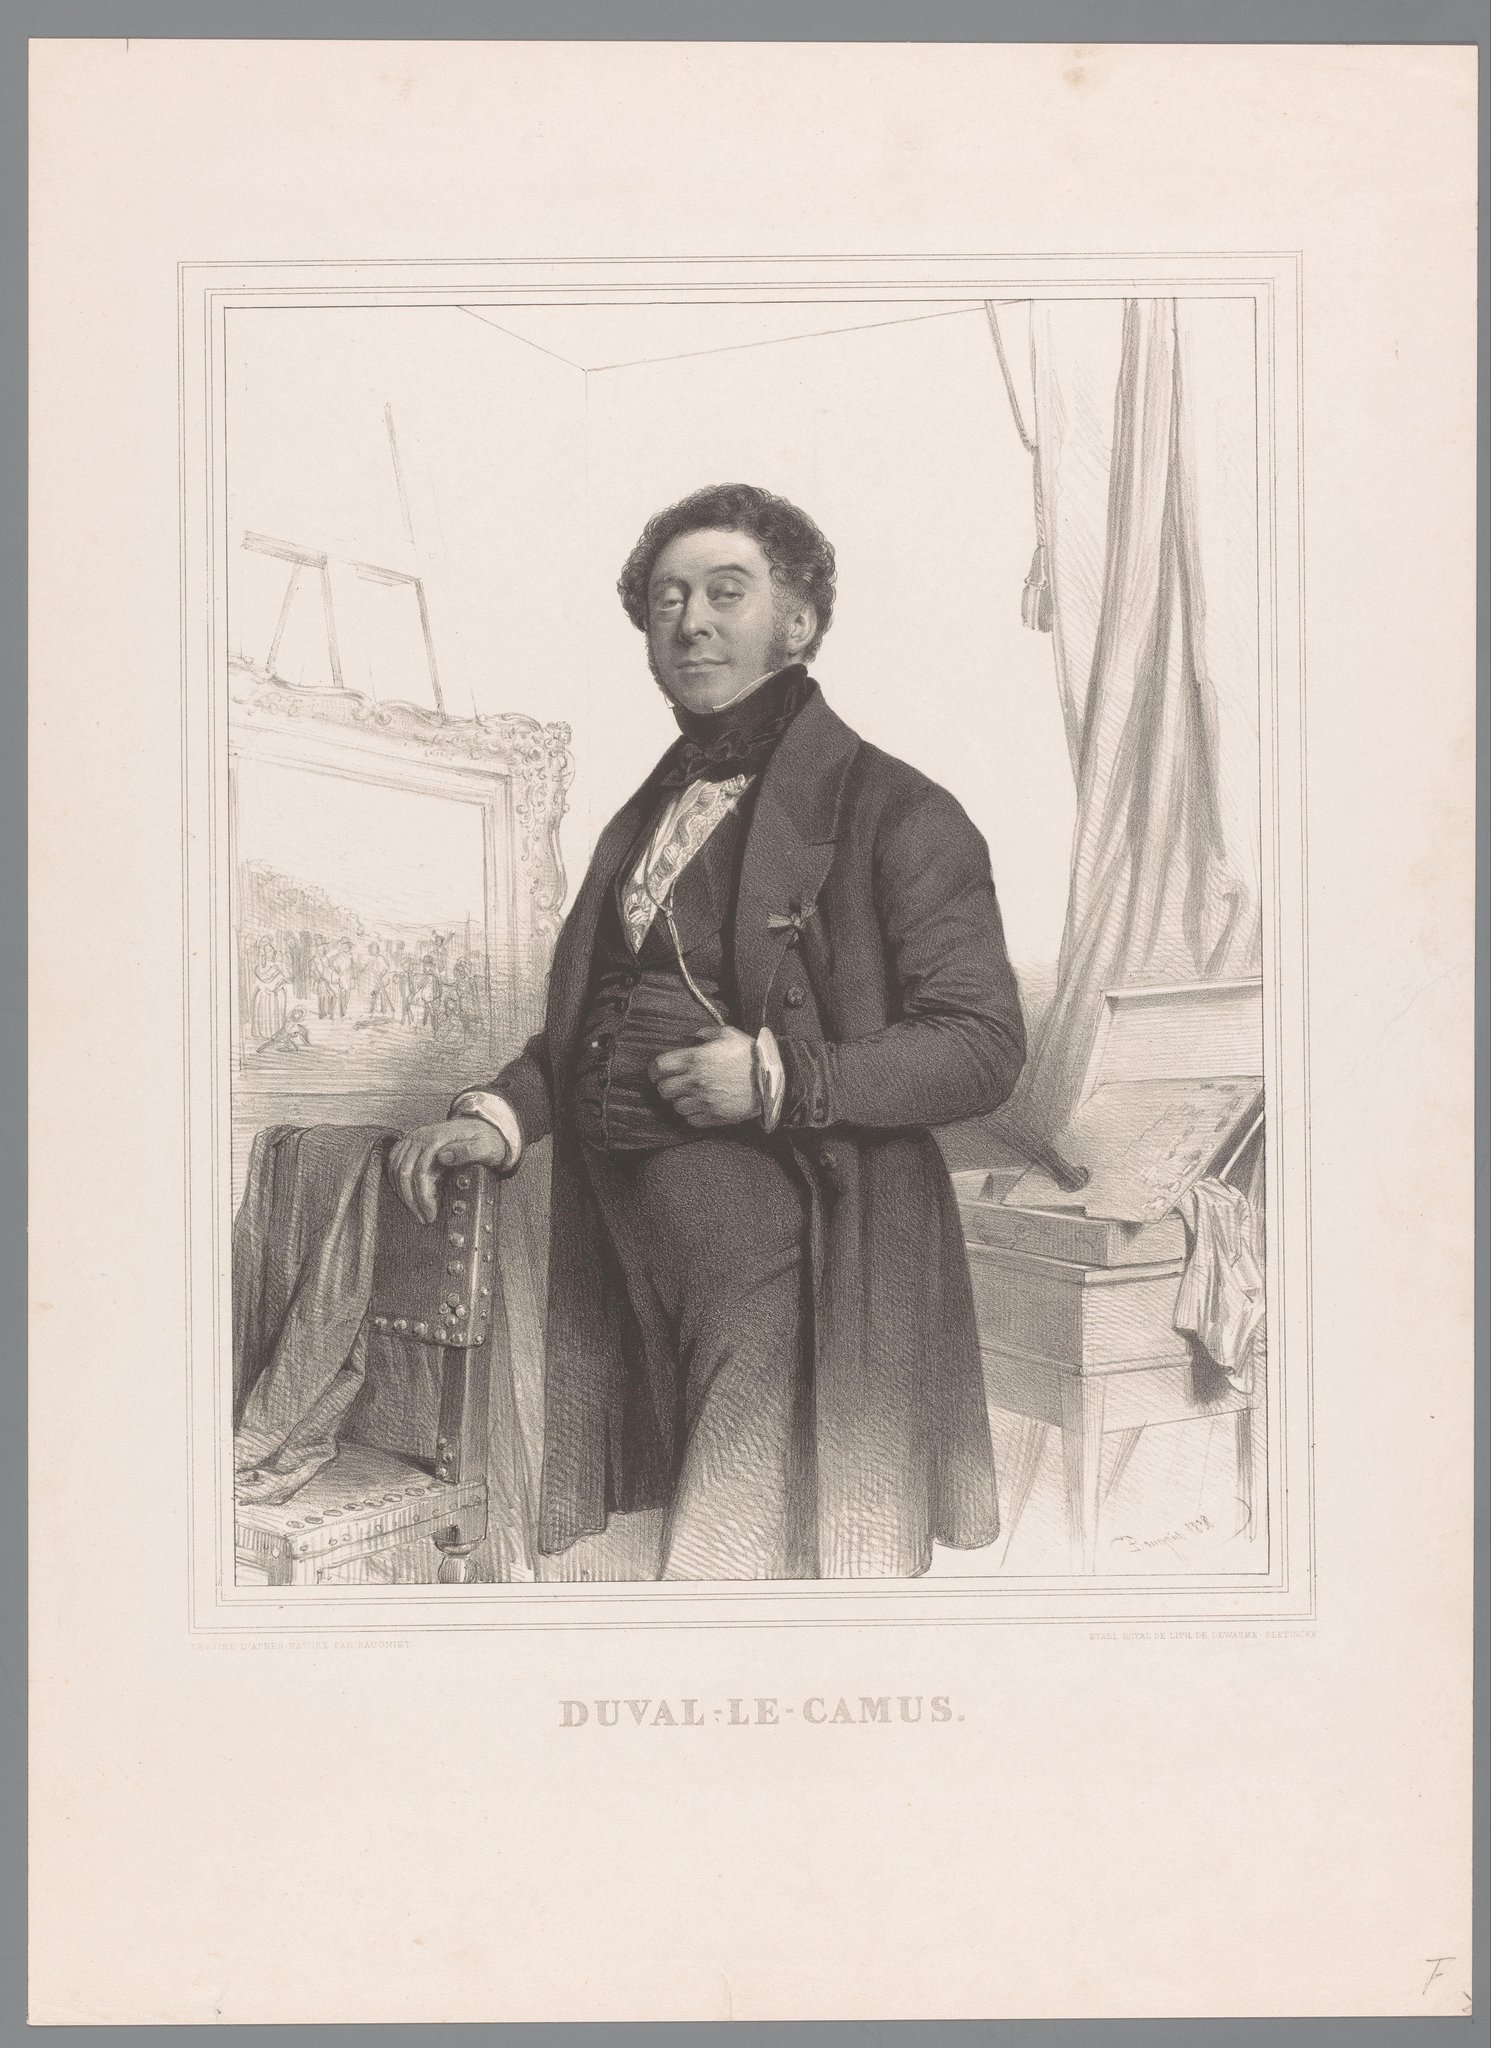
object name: print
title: Duval-Le-Camus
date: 1838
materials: paper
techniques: lithograph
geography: brussels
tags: painter, print maker, pierre duval-lecamus, adult man, historical persons, portrait, self-portrait of painter, tools, implements of painter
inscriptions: collector's mark: Lugt 2228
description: Prent verschenen in: Baugniet, Charles. Les artistes contemporains: portraits lithographiés d'après nature, accompagnés de notices sur la vie et les ouvrages de chacun d'eux. Brussel: De Wasme-Pletinckx, [1836-1840].